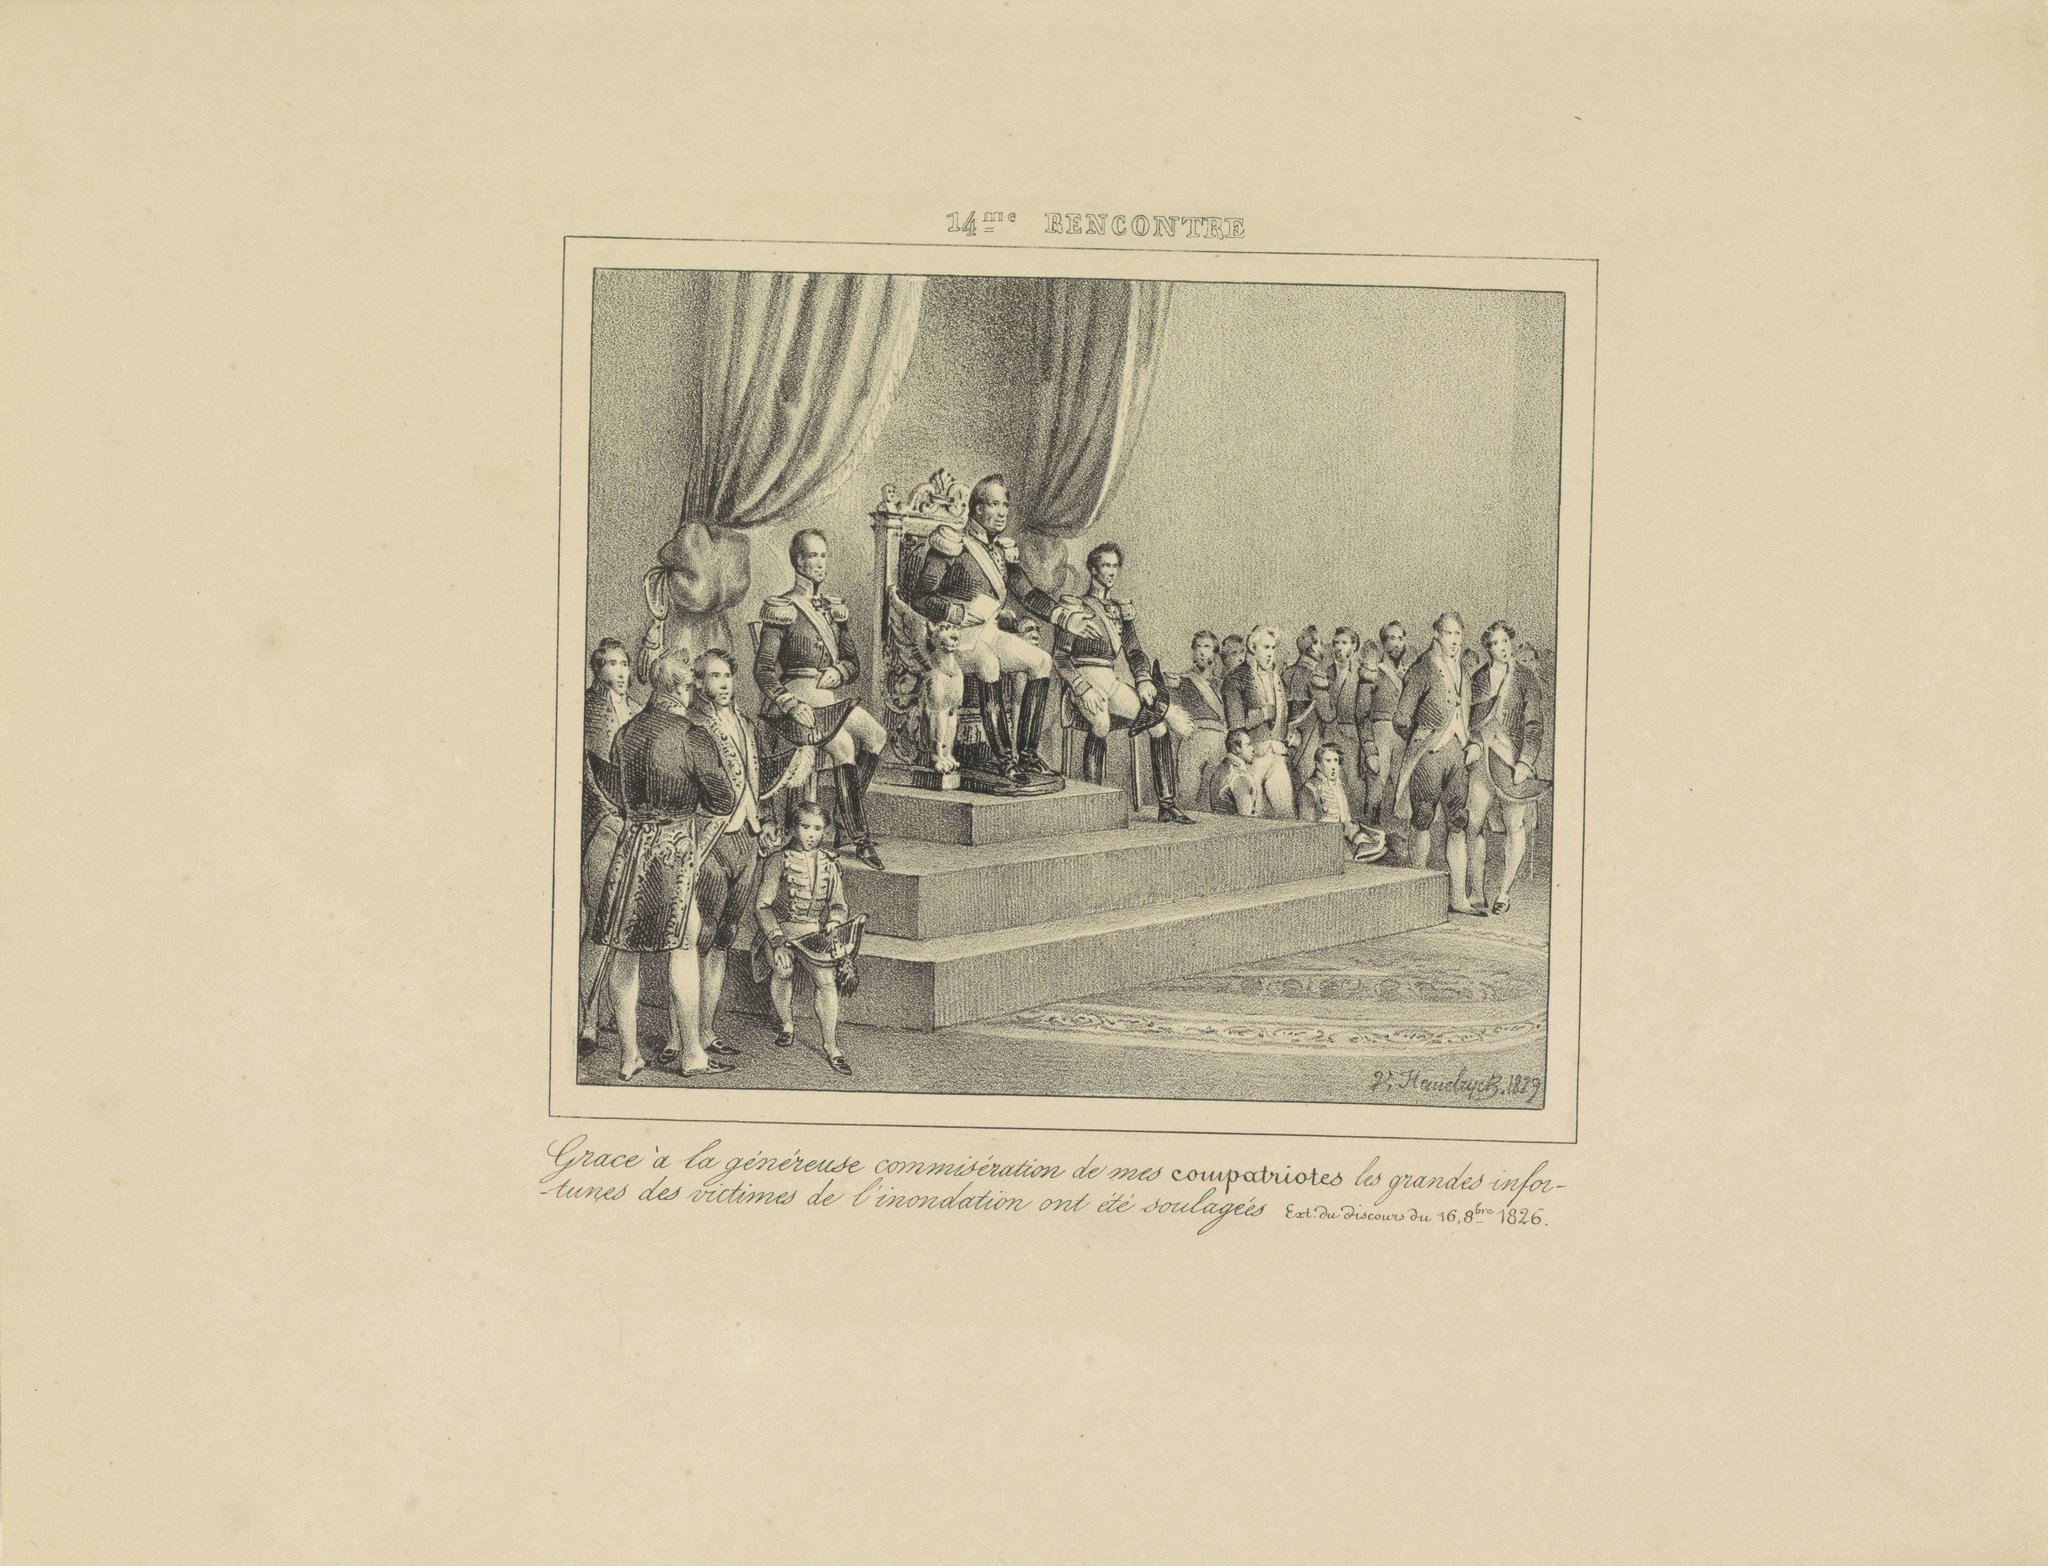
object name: print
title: 14me. rencontre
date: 1829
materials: paper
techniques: lithograph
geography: brussels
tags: the hague, berlin, william i of the netherlands, william ii of the netherlands, frederik (prins der nederlanden), popular representation ~ government, official acts of rulers, e.g. royal acts (ruler giving audience, granting mercy, etc.; ruler and his subjects)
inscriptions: collector's mark: Lugt 2228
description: Koning Willem I dankt bij opening van de Kamers op 16 oktober 1826 zijn landgenoten voor de hulp verleend aan de slachtoffers van de watersnood. De koning zit op zijn troon. Aan weerszijden van hem zitten zijn zoons, de kroonprins en prins Frederik. Met tweeregelig onderschrift. Onderdeel van de serie van 24 platen met ontmoetingen met koning Willem I, verschenen onder de titel 'Les rencontres' in 1829-1830.